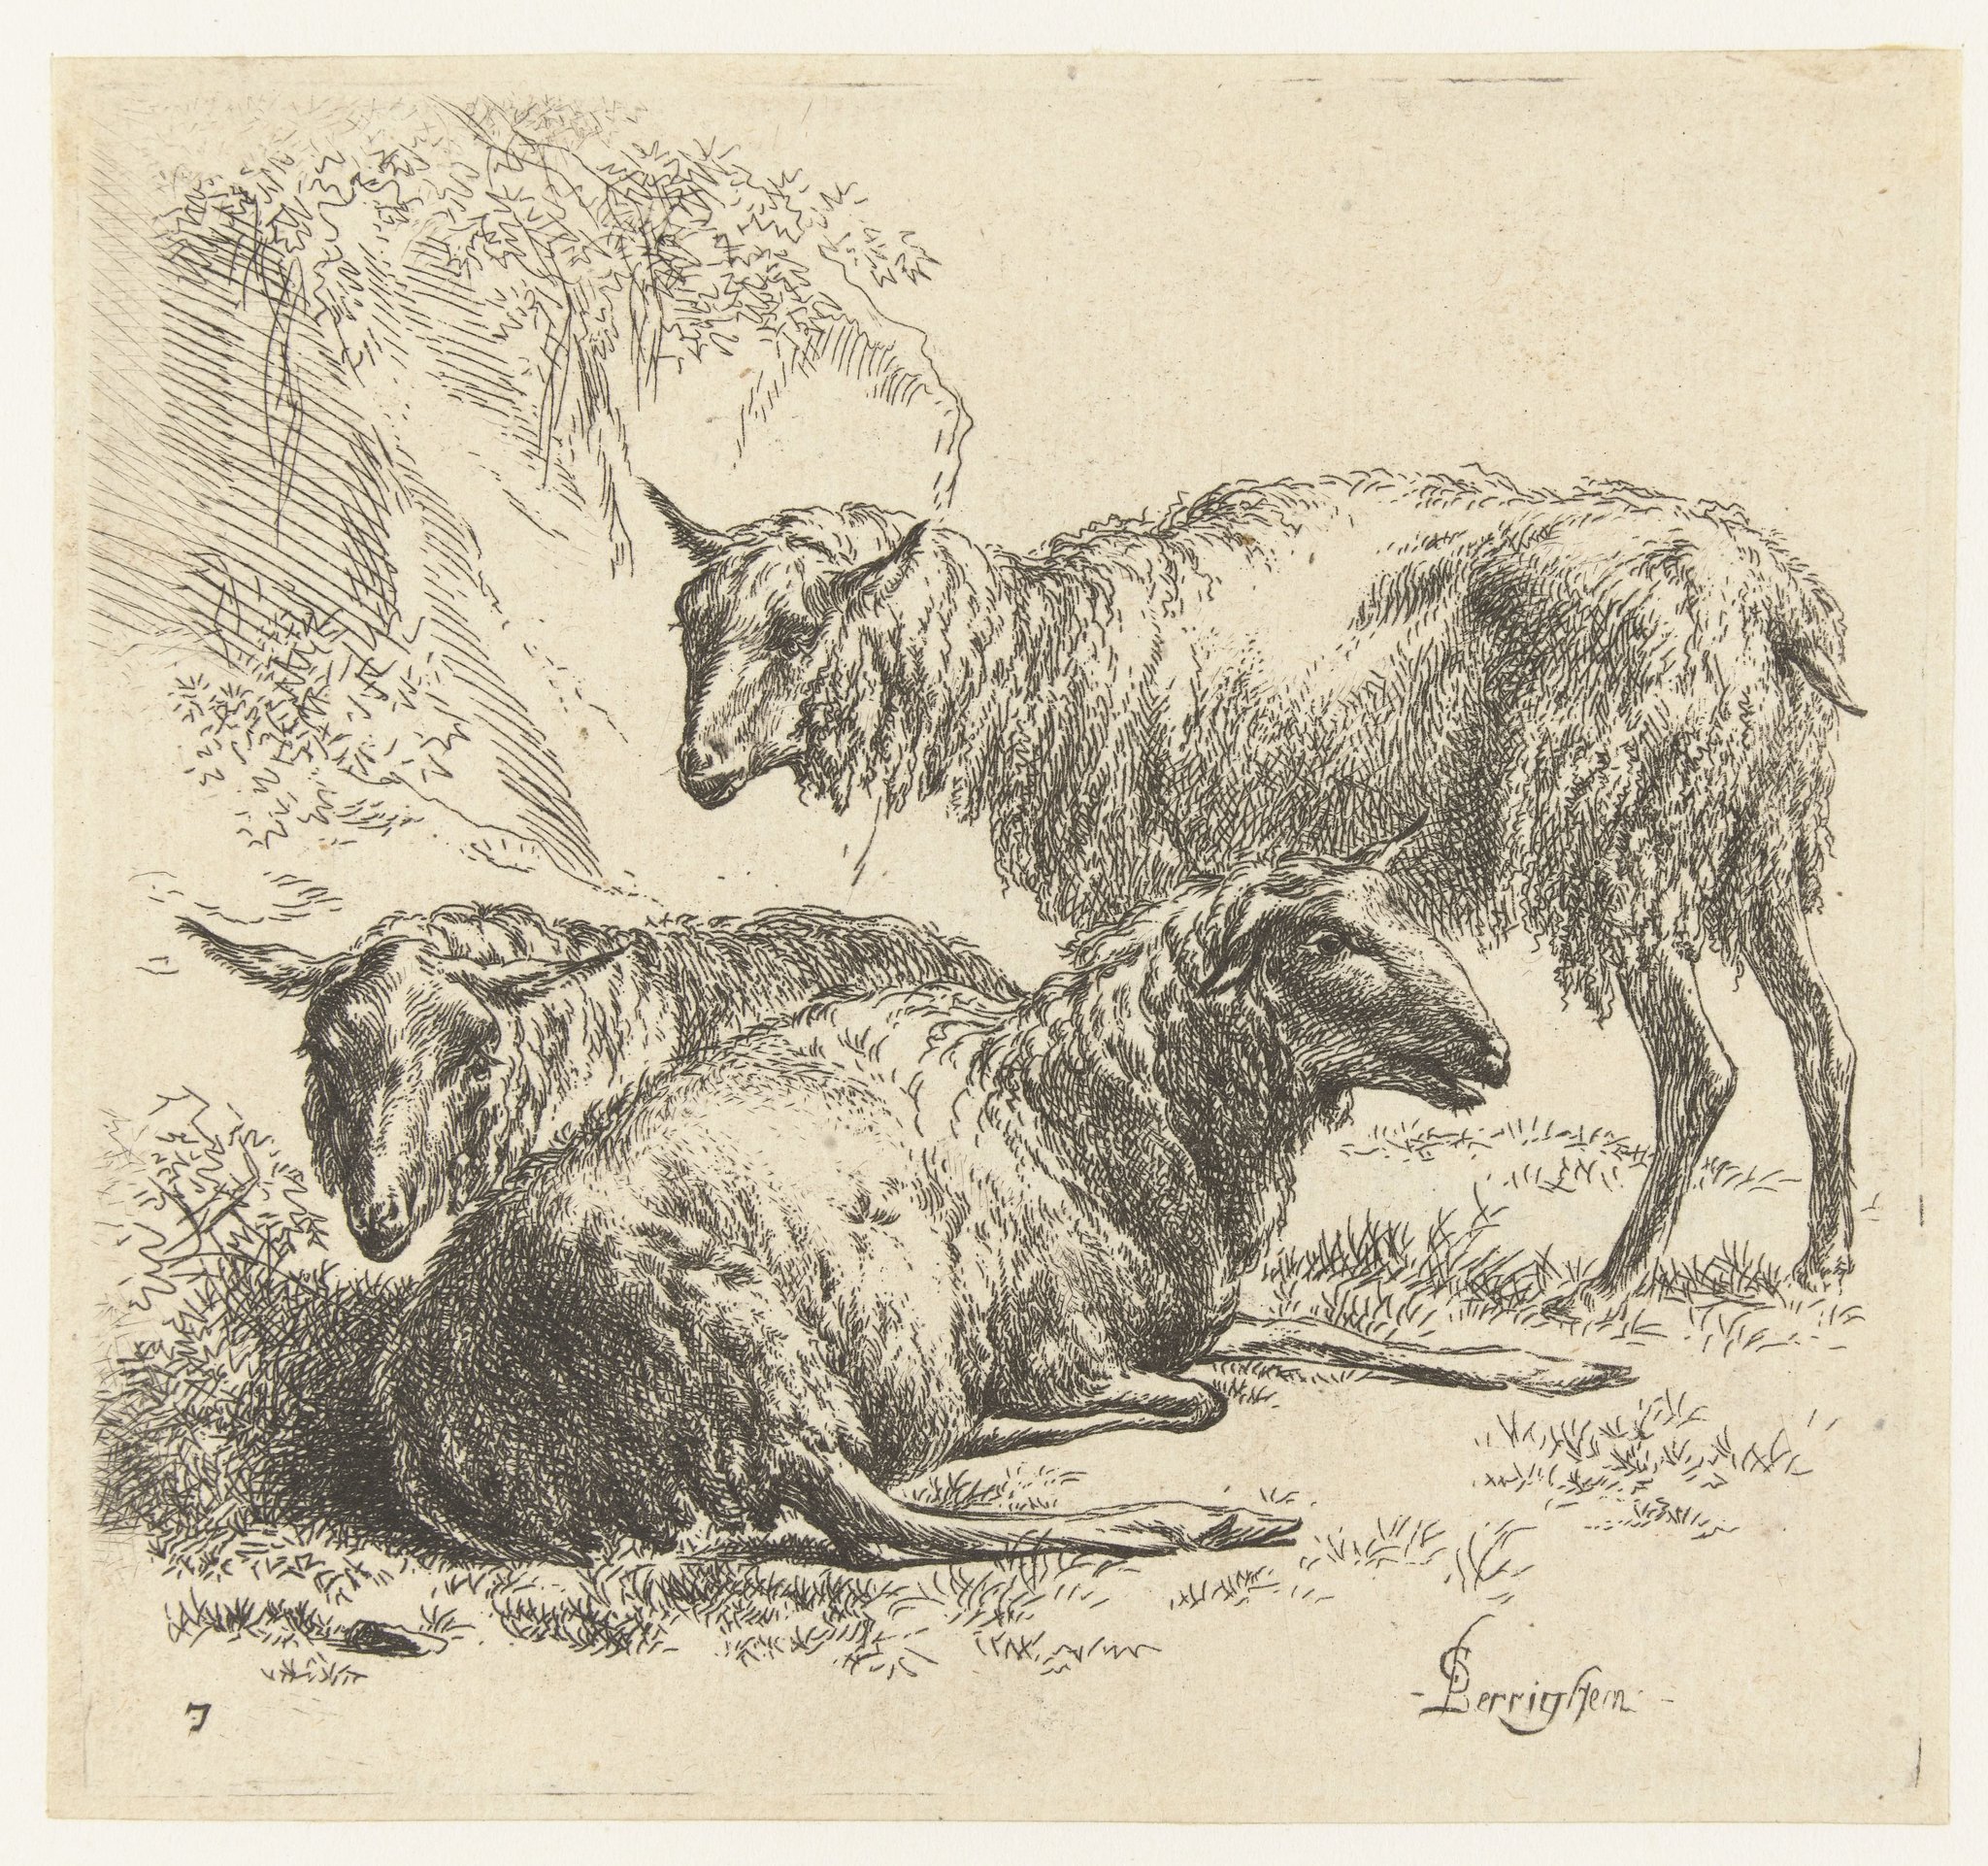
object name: print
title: Schapen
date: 1646-1652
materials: paper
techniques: etching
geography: netherlands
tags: sheep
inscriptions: collector's mark: Lugt 240